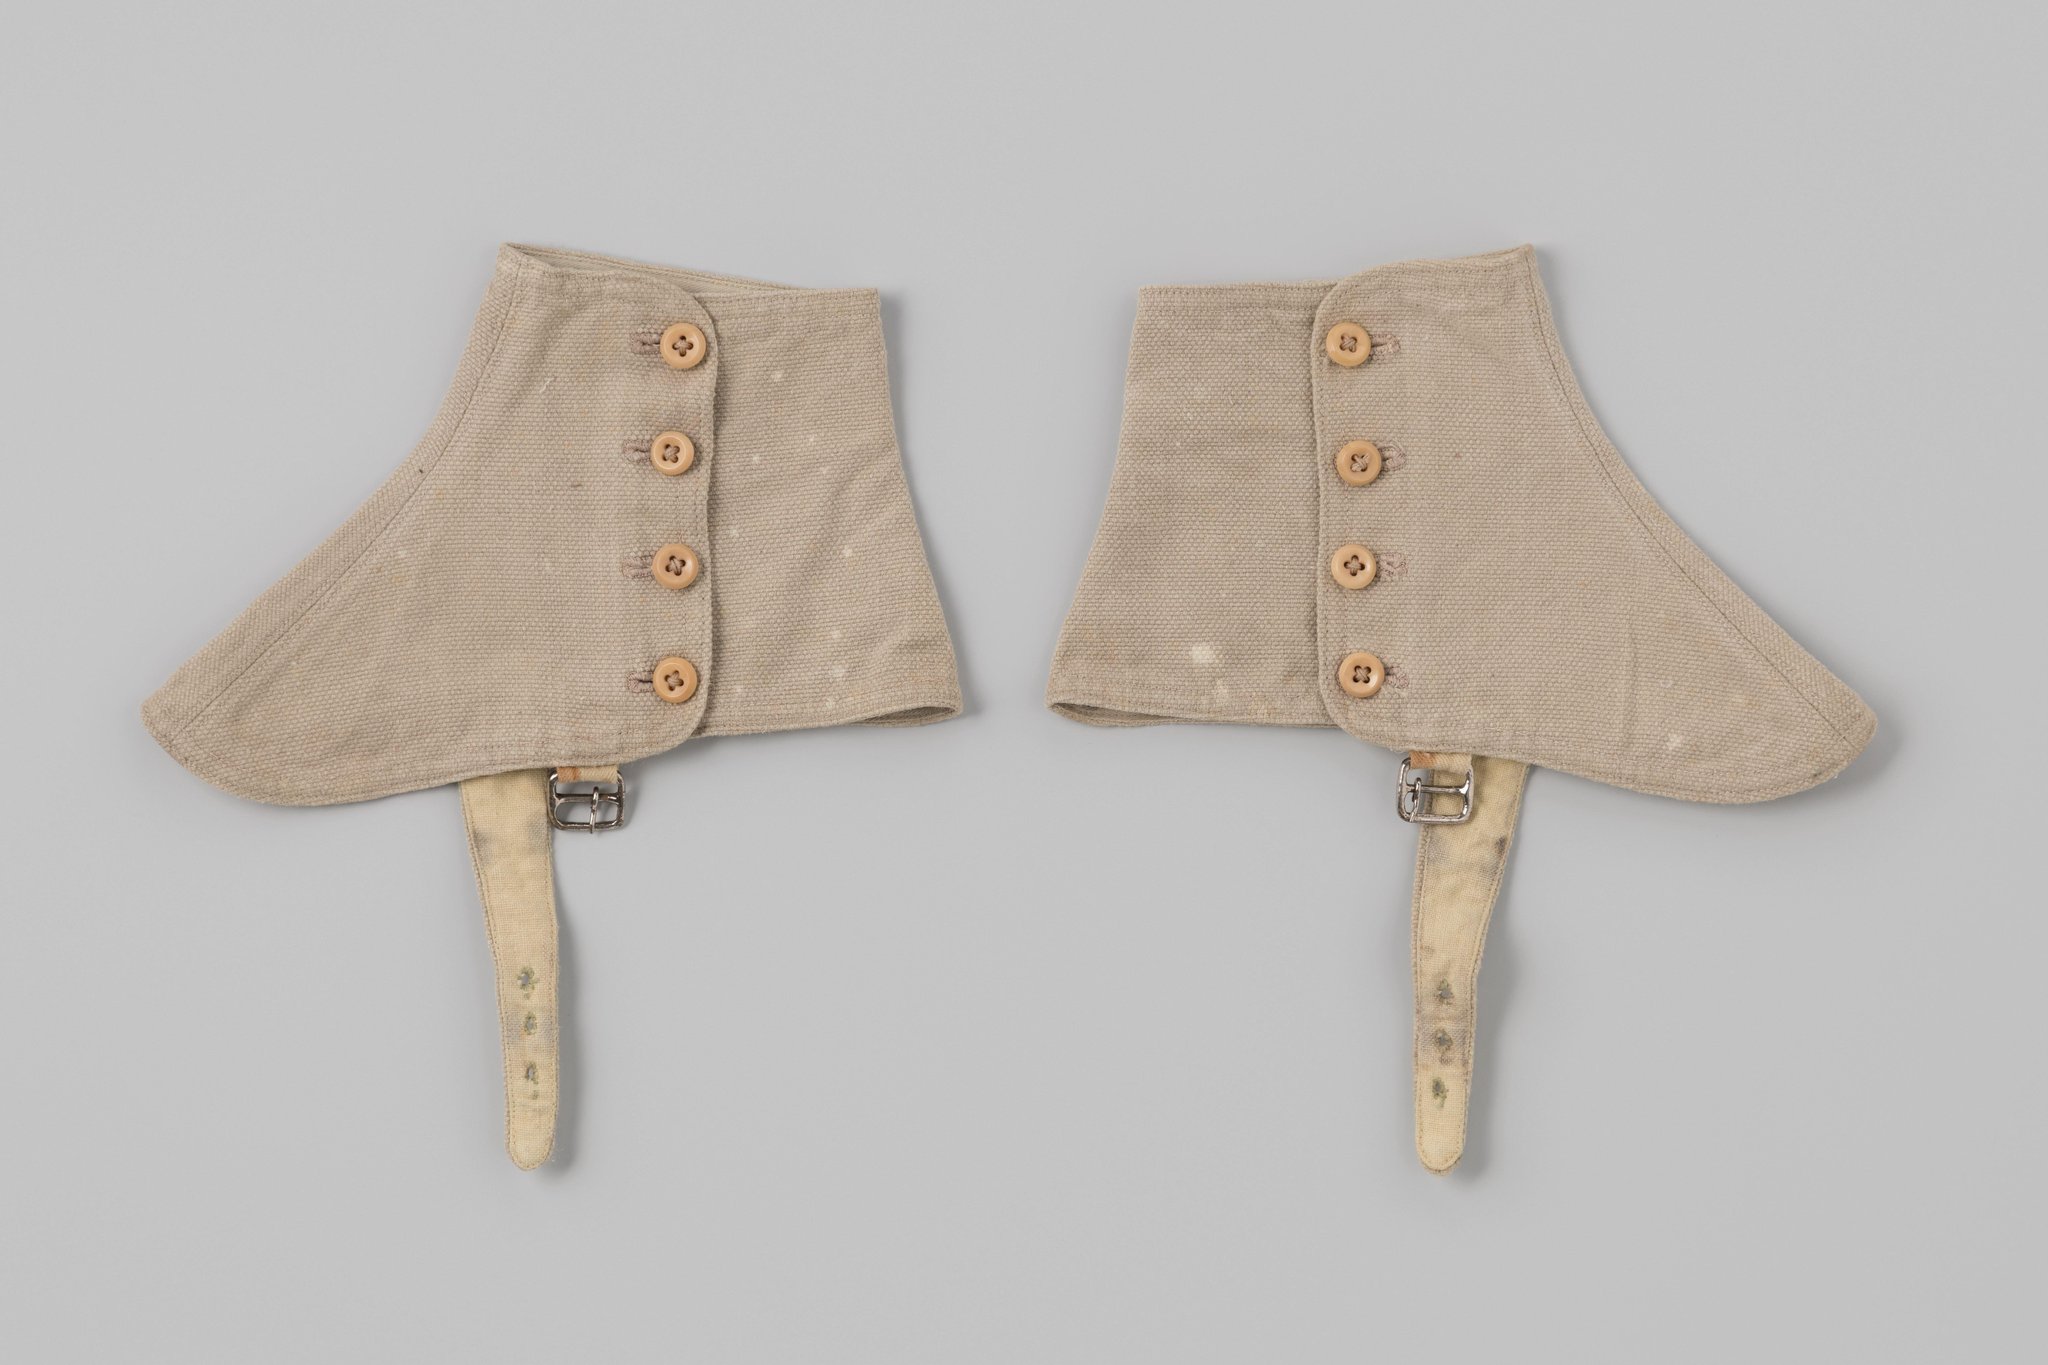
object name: spat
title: Slobkous van zandkleurig linnenkatoen, waarop vier beige knopen en een linnen riem met metalen gesp onder de voet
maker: Anonymous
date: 1900-1930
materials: cotton, metal, plastic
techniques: weave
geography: netherlands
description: Slobkous van zandkleurig linnenkatoen, waarop vier beige knopen en een linnen riem met metalen gesp onder de voet. Ongevoerd maar verstevigd met katoenen biesen.